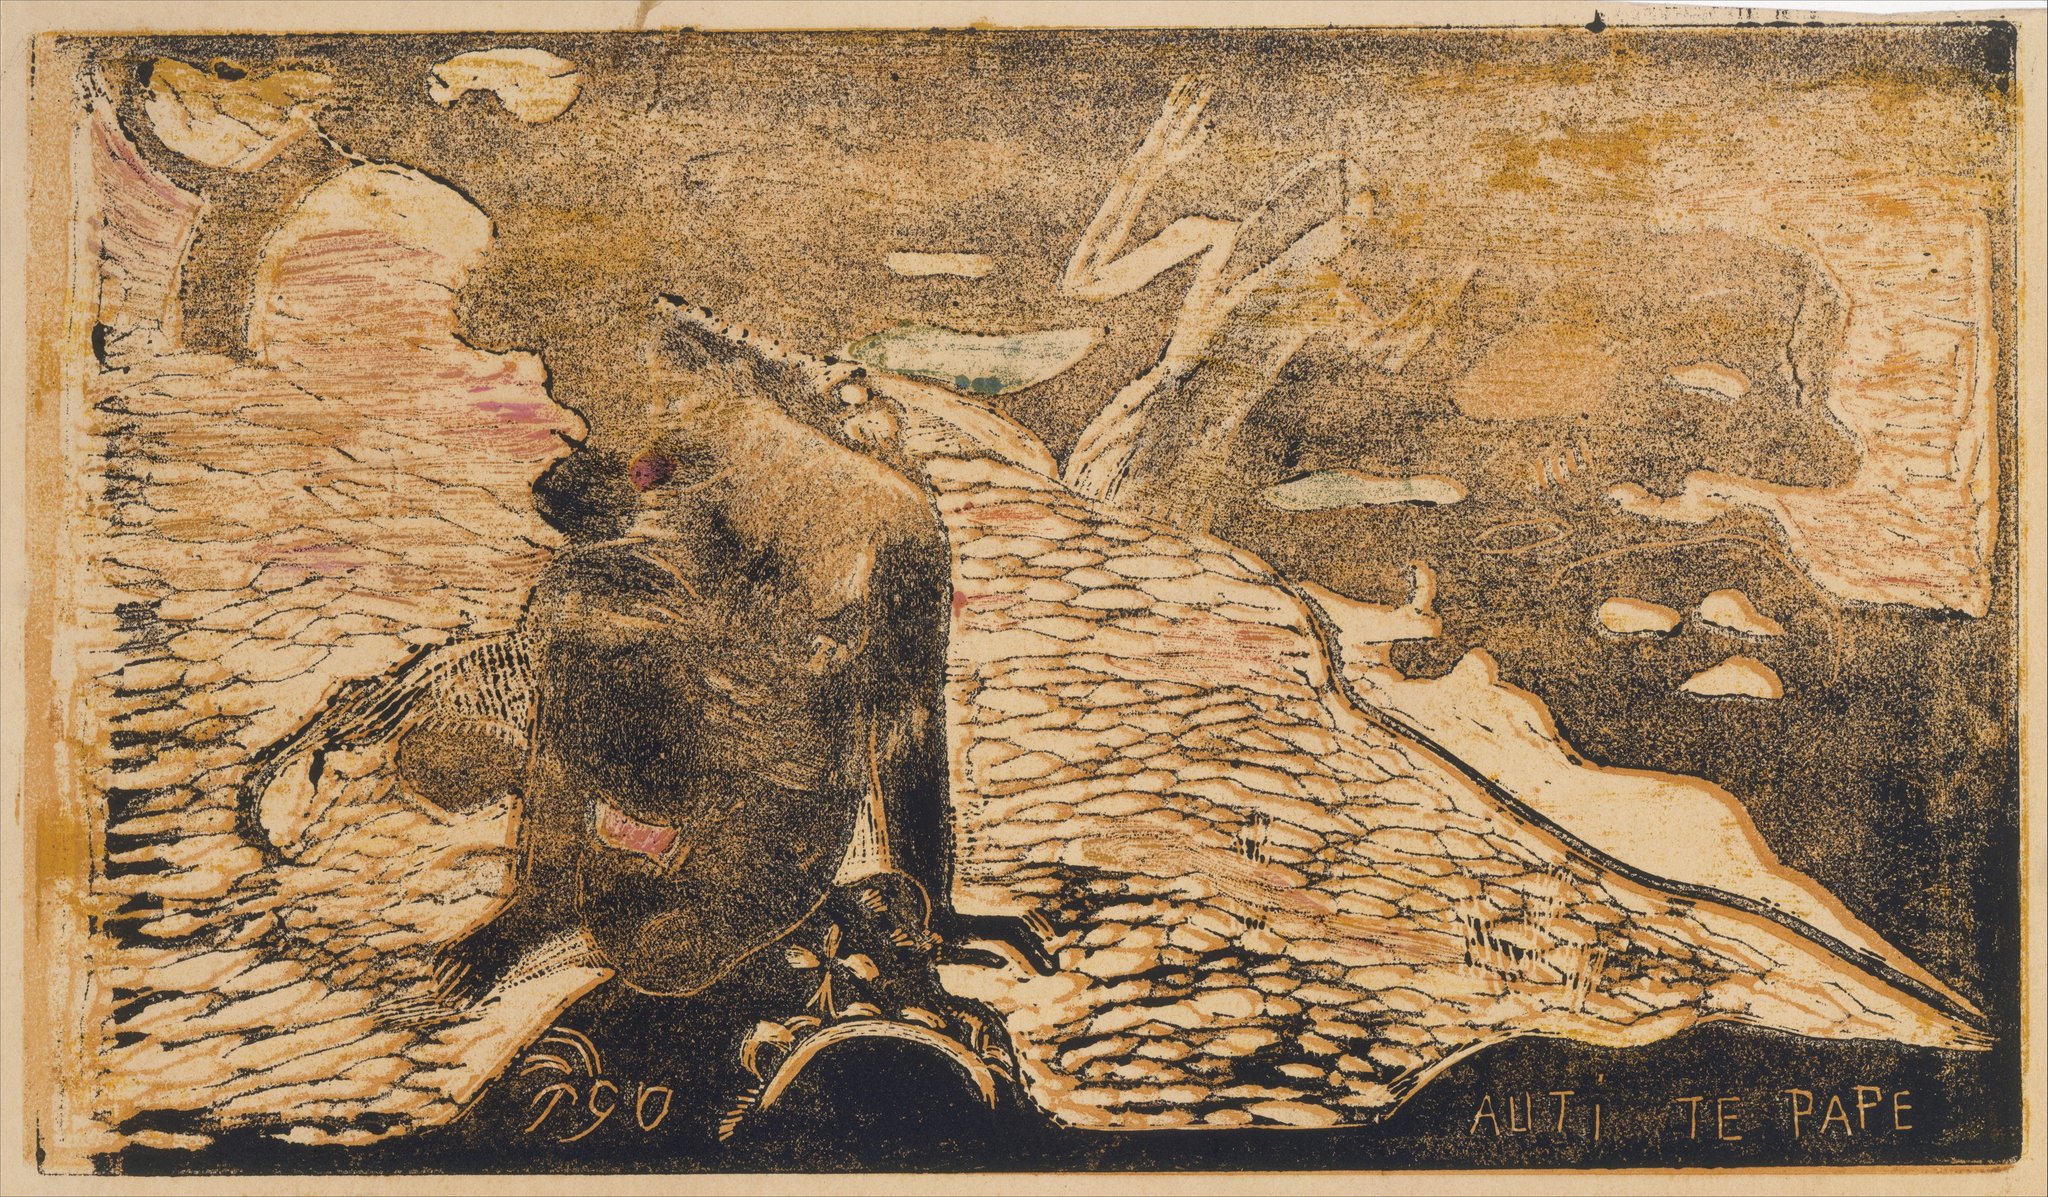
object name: print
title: Auti Te Pape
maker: paul gauguin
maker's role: artist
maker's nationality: french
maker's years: 1848-1903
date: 1893-1894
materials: paper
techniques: printing, woodcut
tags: female nudes,rivers